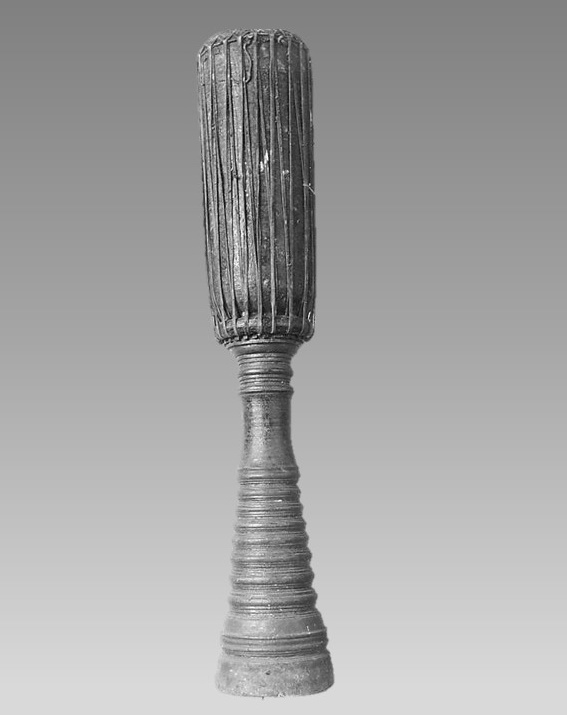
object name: klong yao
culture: thai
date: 1867-1900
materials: skin, wood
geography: thailand